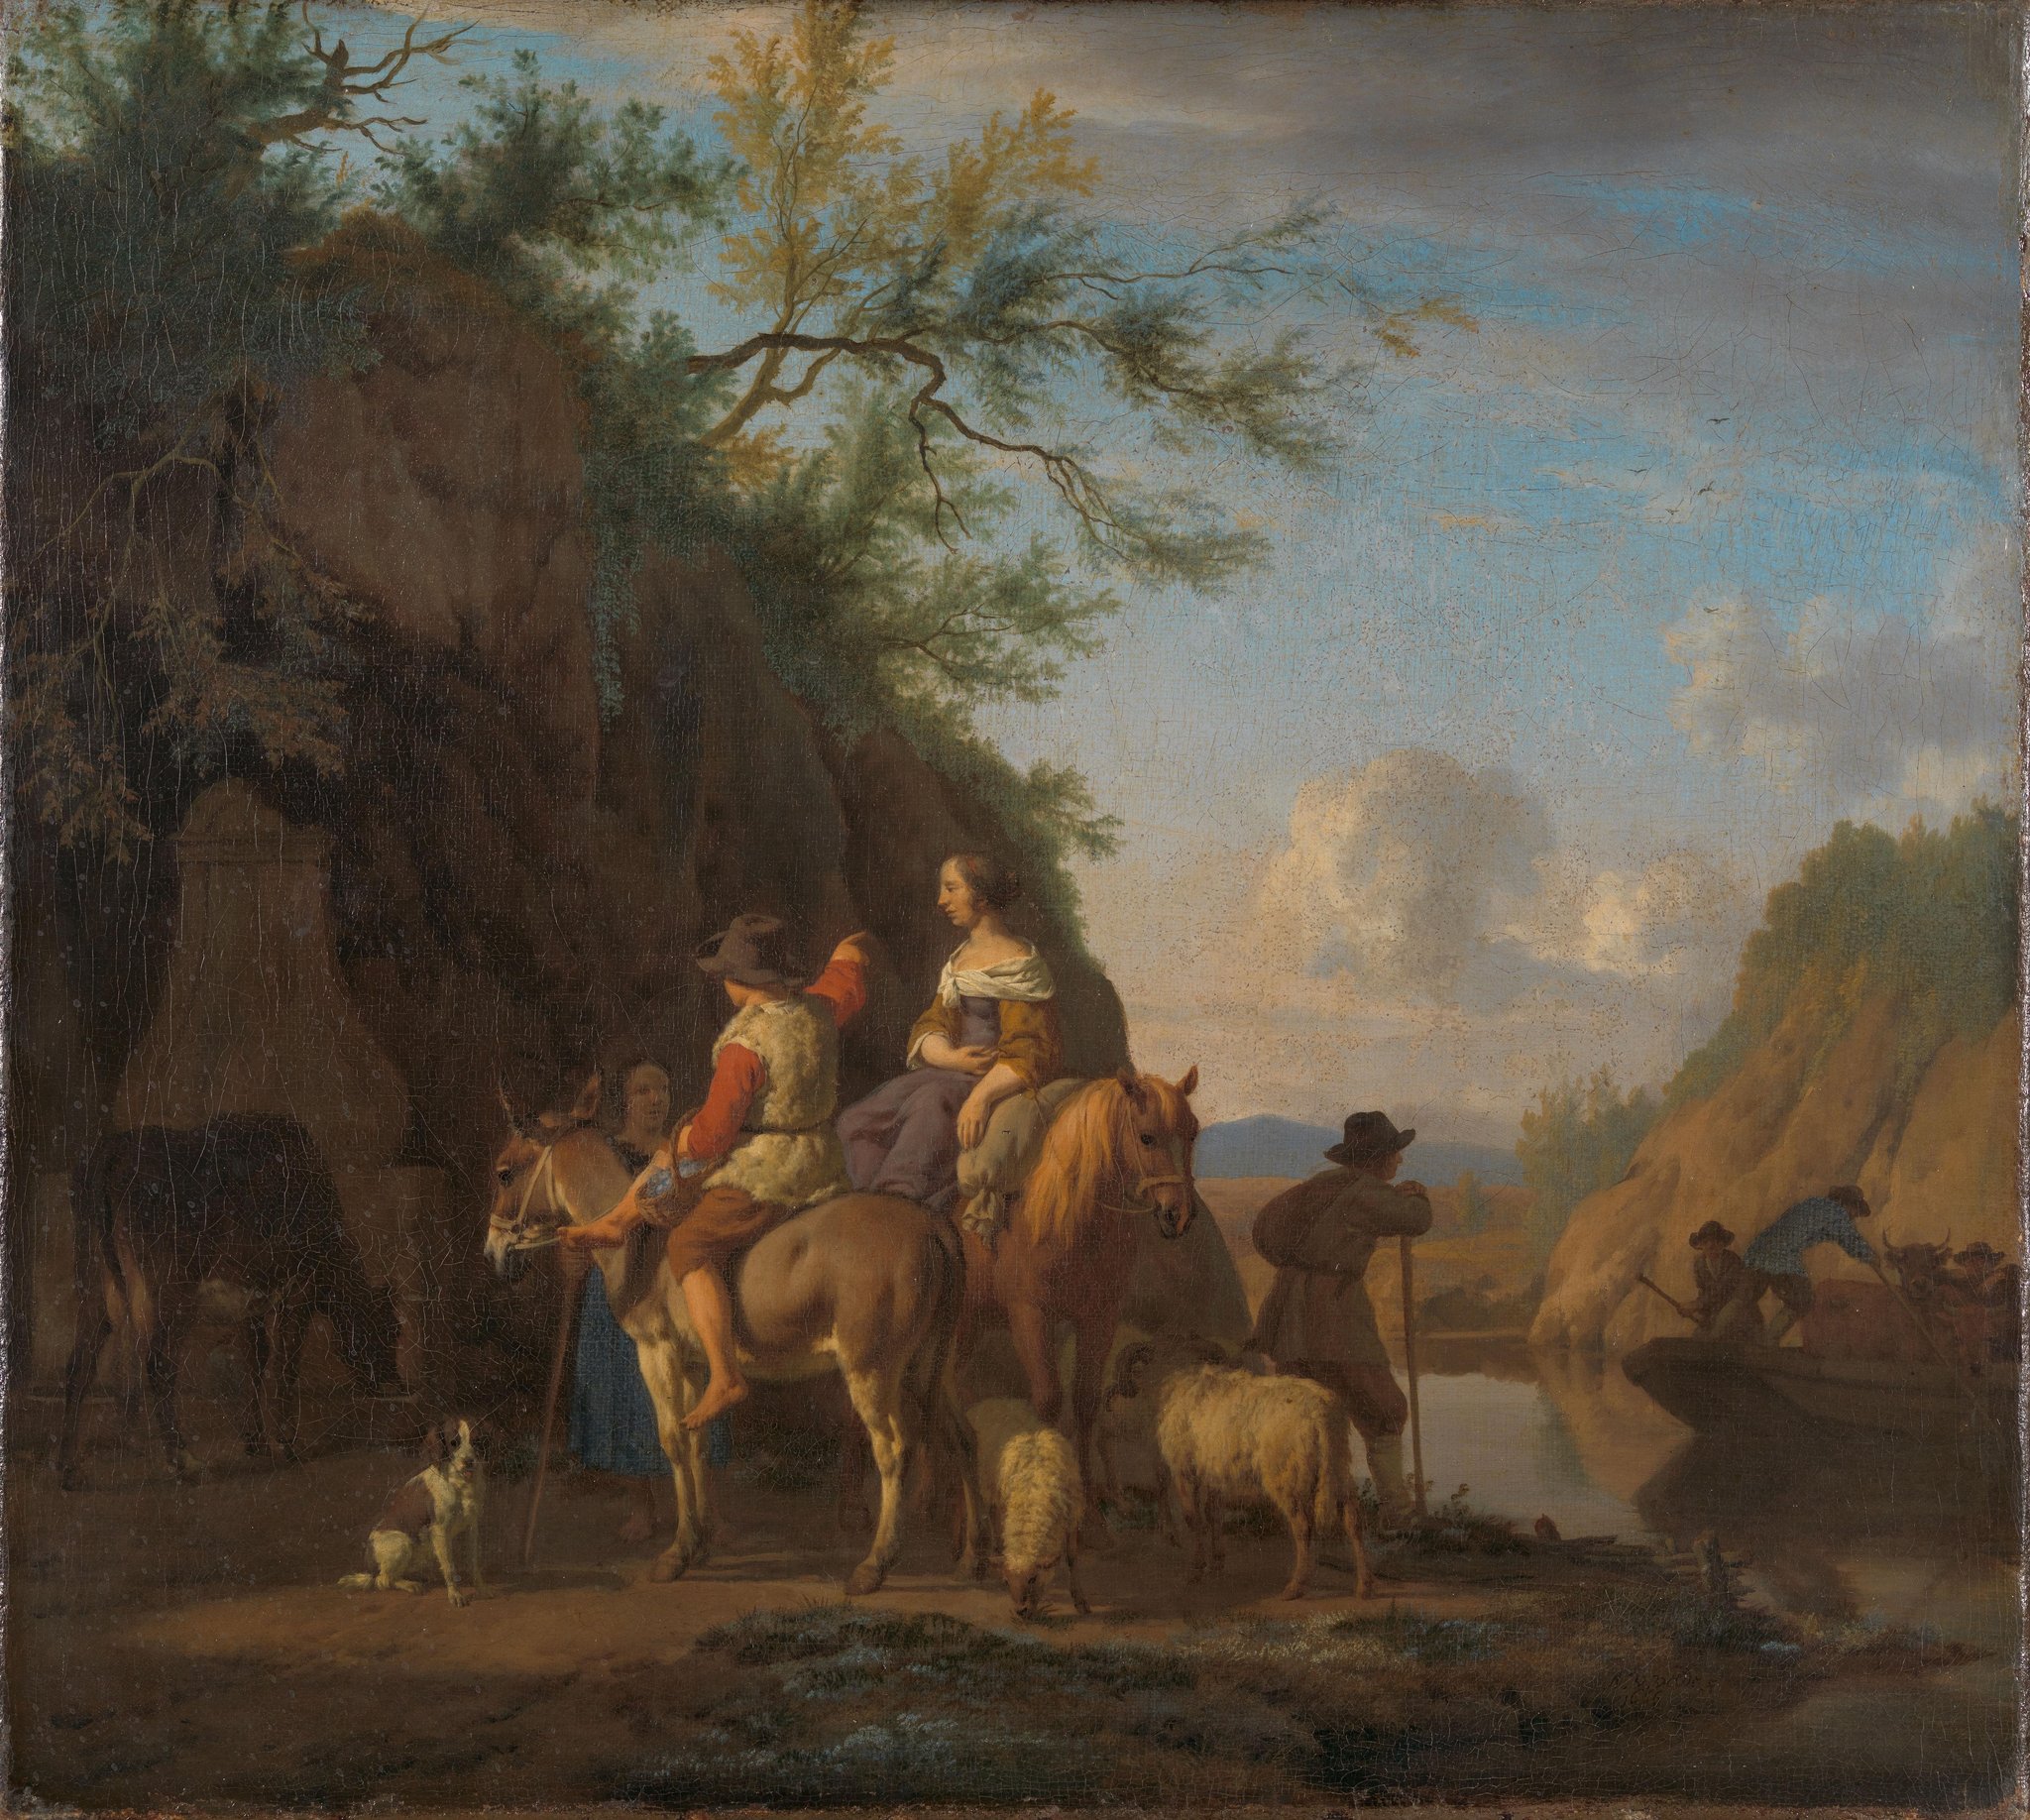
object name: painting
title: Ferry Boat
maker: adriaen van de velde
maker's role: draughtsman, painter, print maker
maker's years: 1636-1672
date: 1666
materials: canvas, oil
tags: herding, herdsman, herdswoman, shepherd, shepherdess, cowherd, etc., ferry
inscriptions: signature and date: ‘A. v. Velde f. 1666’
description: Het ponteveer. In een Italiaans landschap wachten aan de oever van een rivier enige herders en herderinnen op de naderende veerpont.